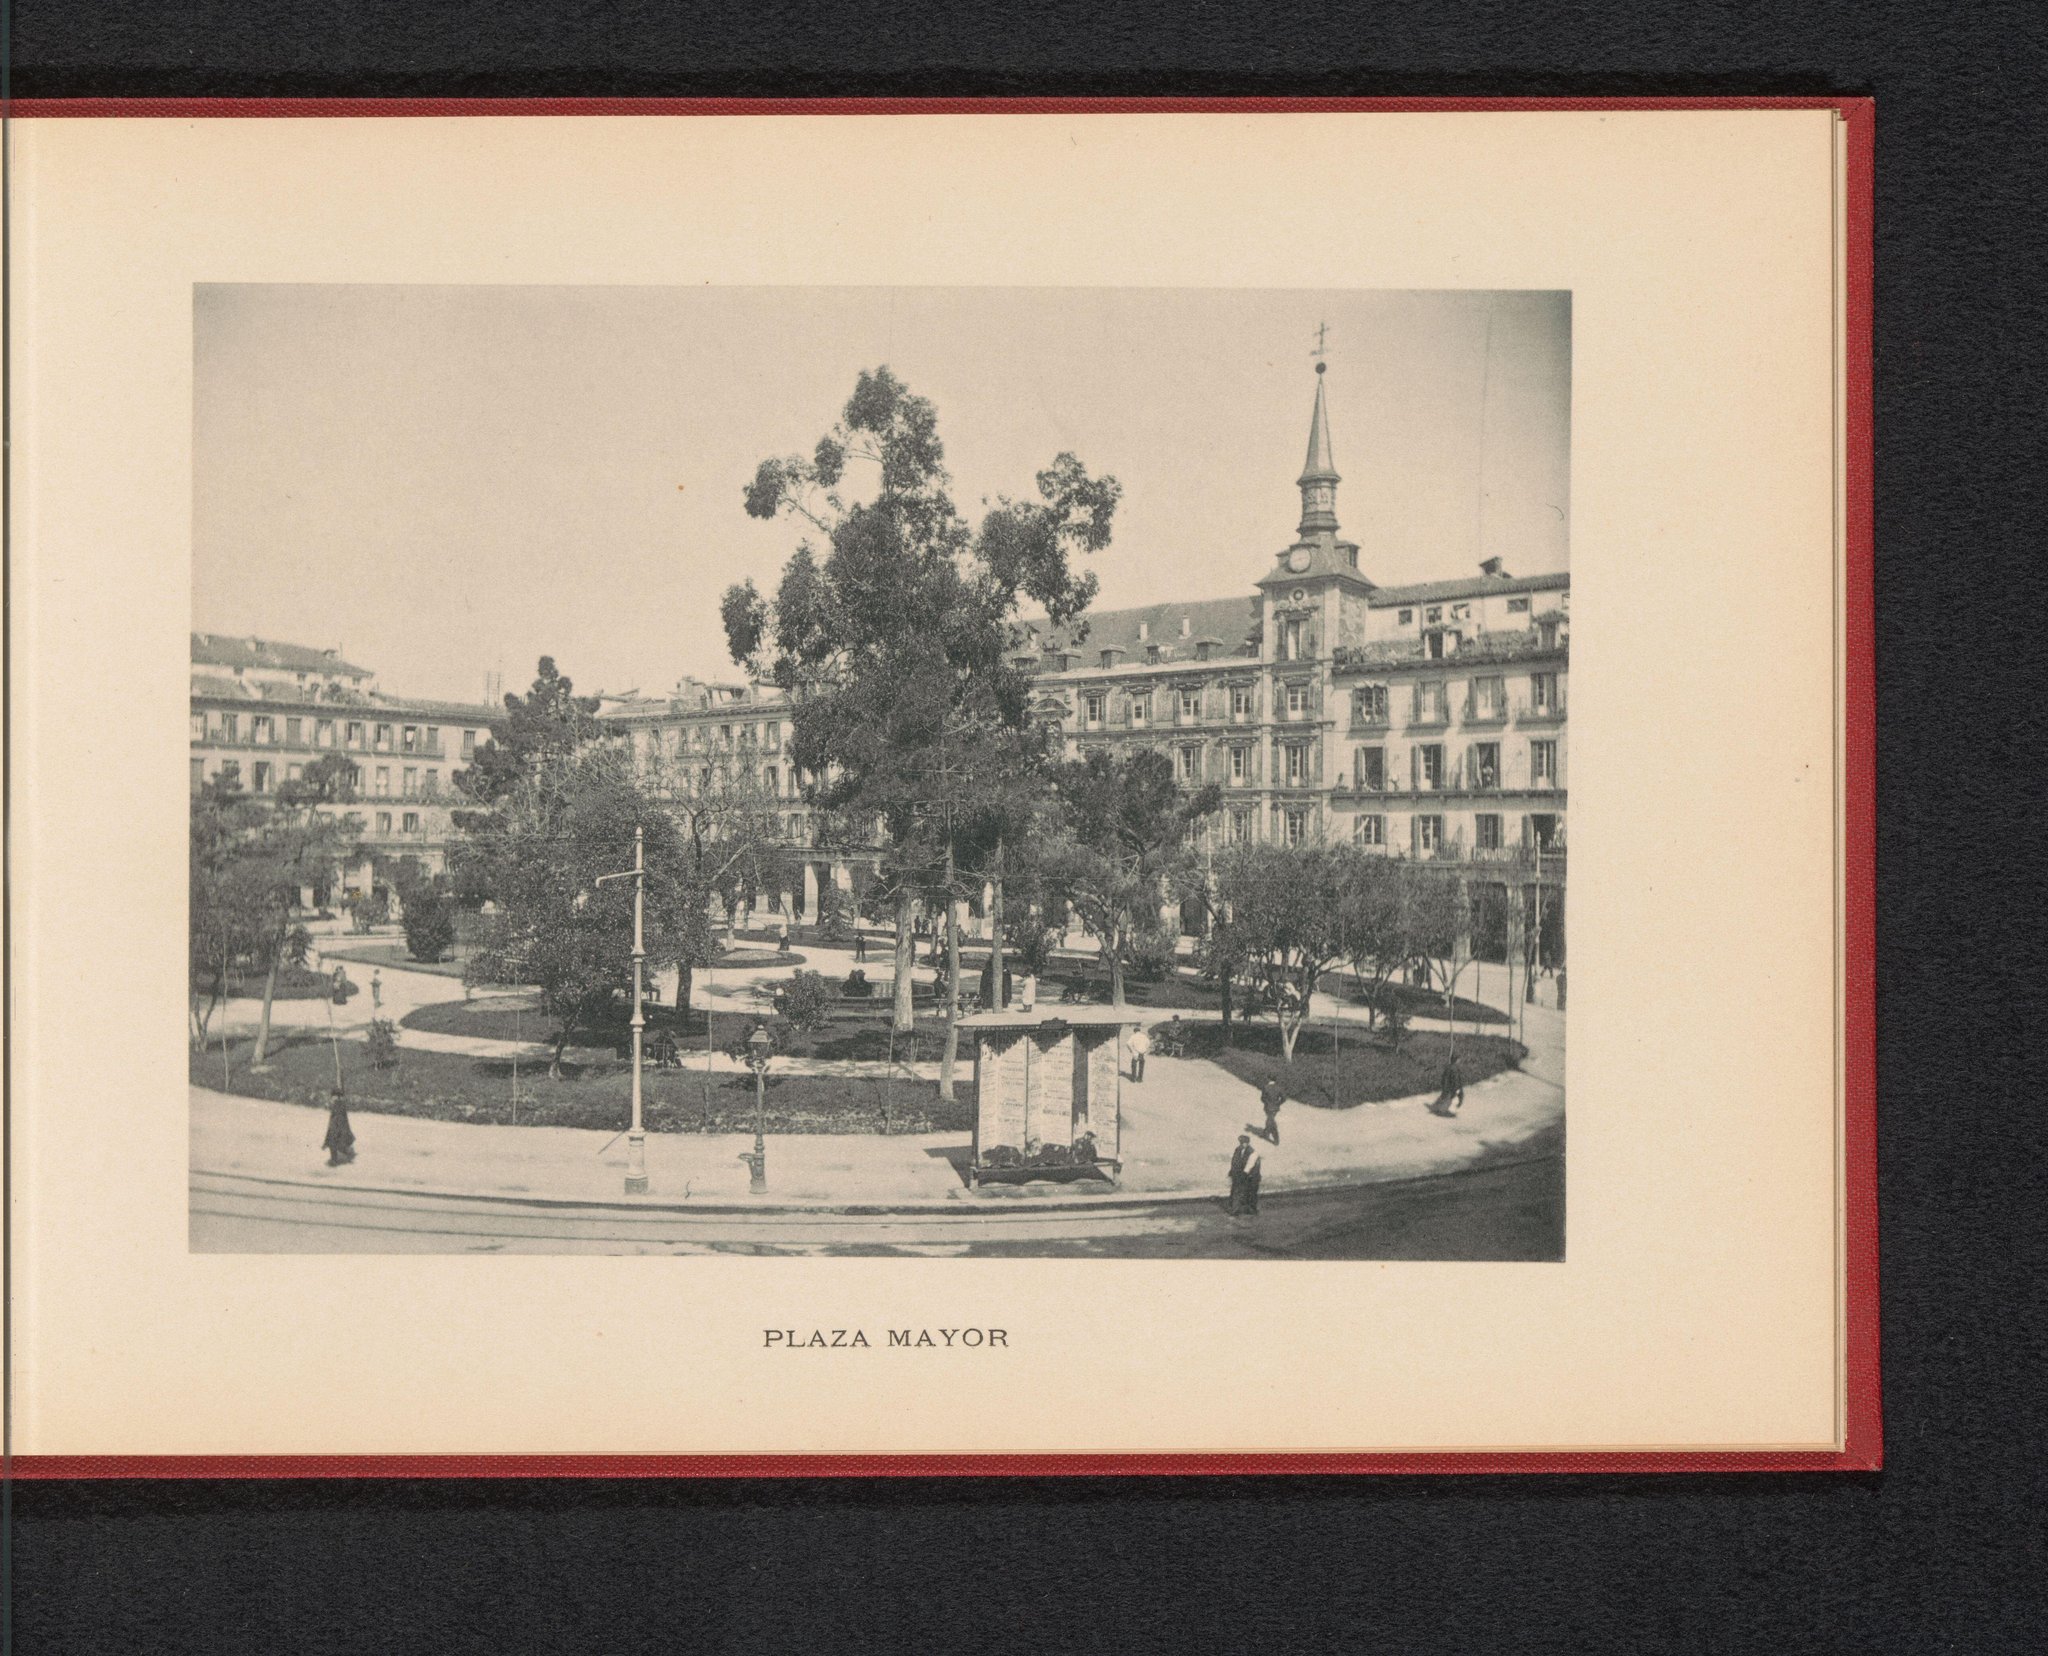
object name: photomechanical print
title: Gezicht op Plaza Mayor in Madrid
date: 1888-1898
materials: paper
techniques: photograph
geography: madrid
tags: square, place, circus, etc.